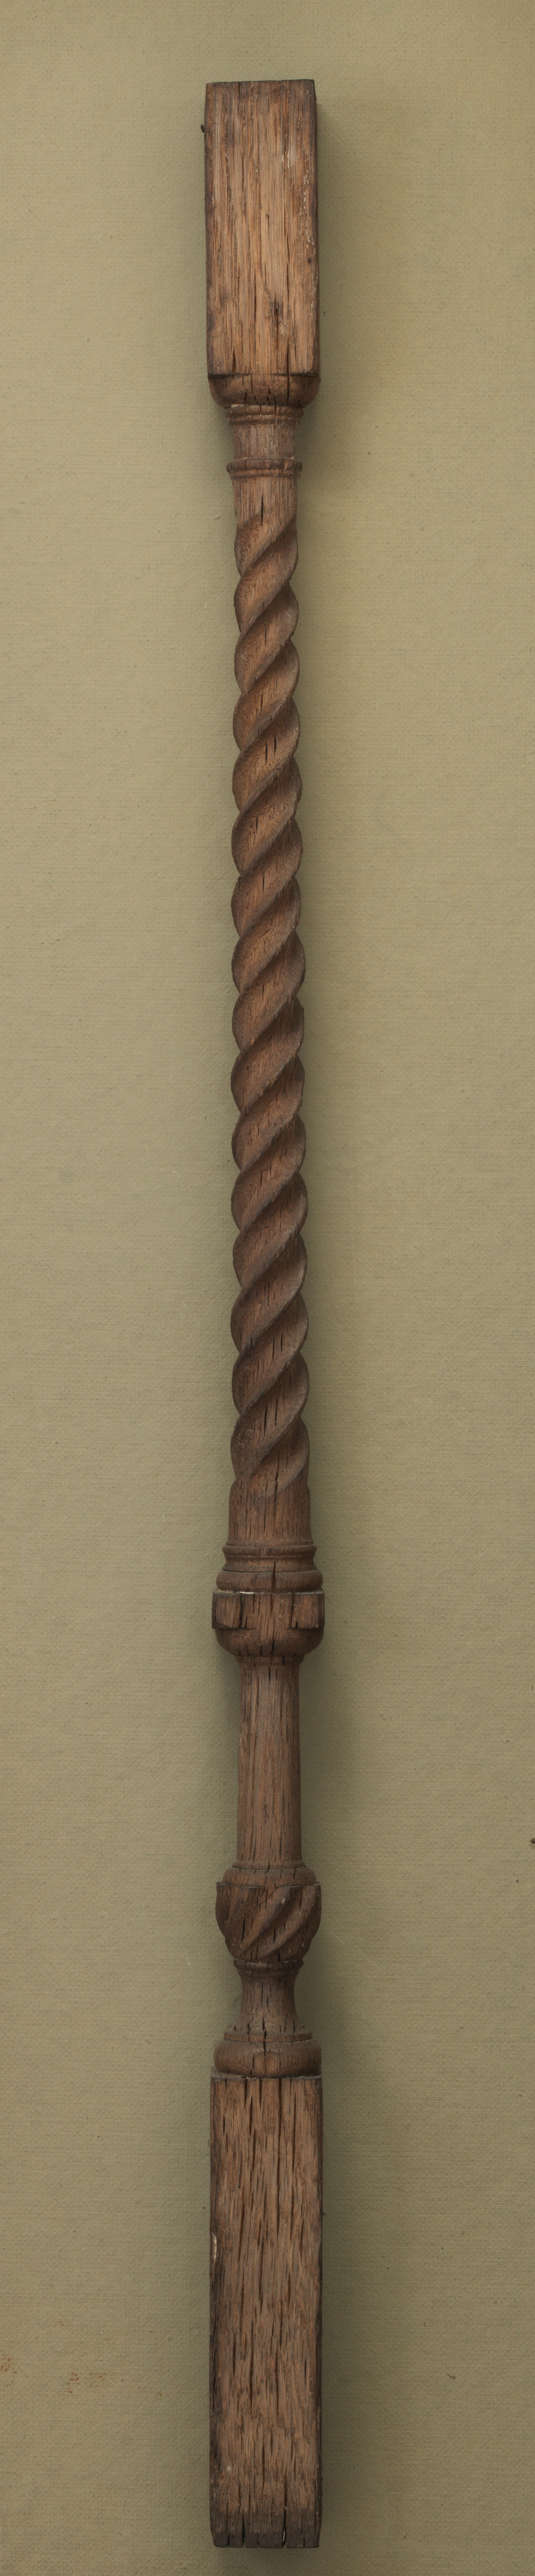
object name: baluster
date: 1734-1766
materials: wood